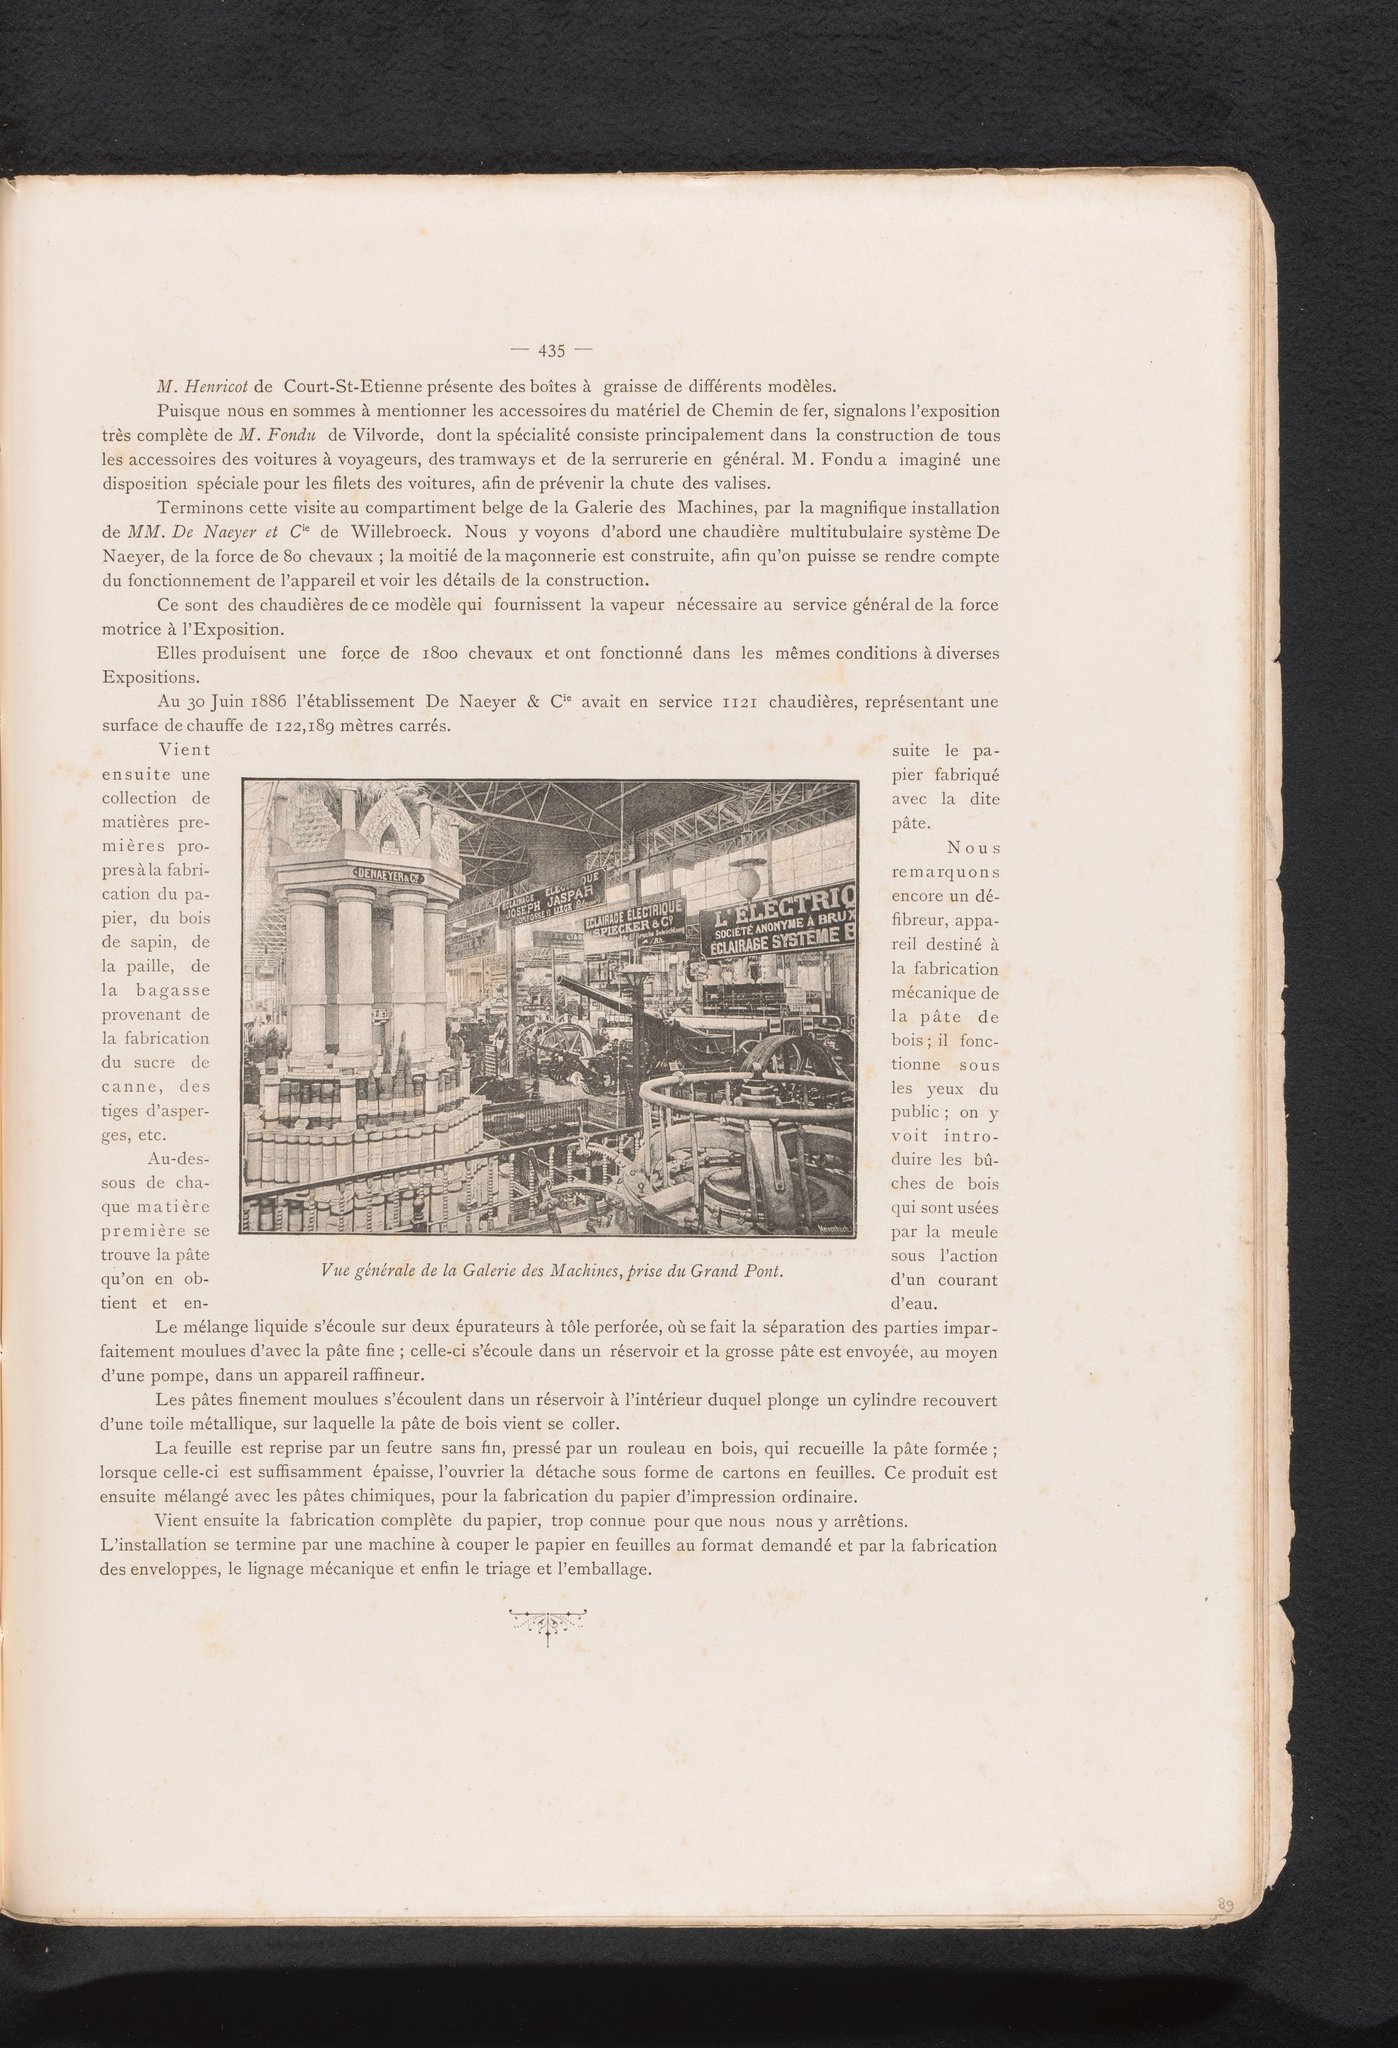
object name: photomechanical print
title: Vue générale de la Galerie des Machines, prise du Grand Pont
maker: Anonymous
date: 1880-1885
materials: paper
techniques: autotype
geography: antwerp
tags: world fair, world exhibition, antwerp